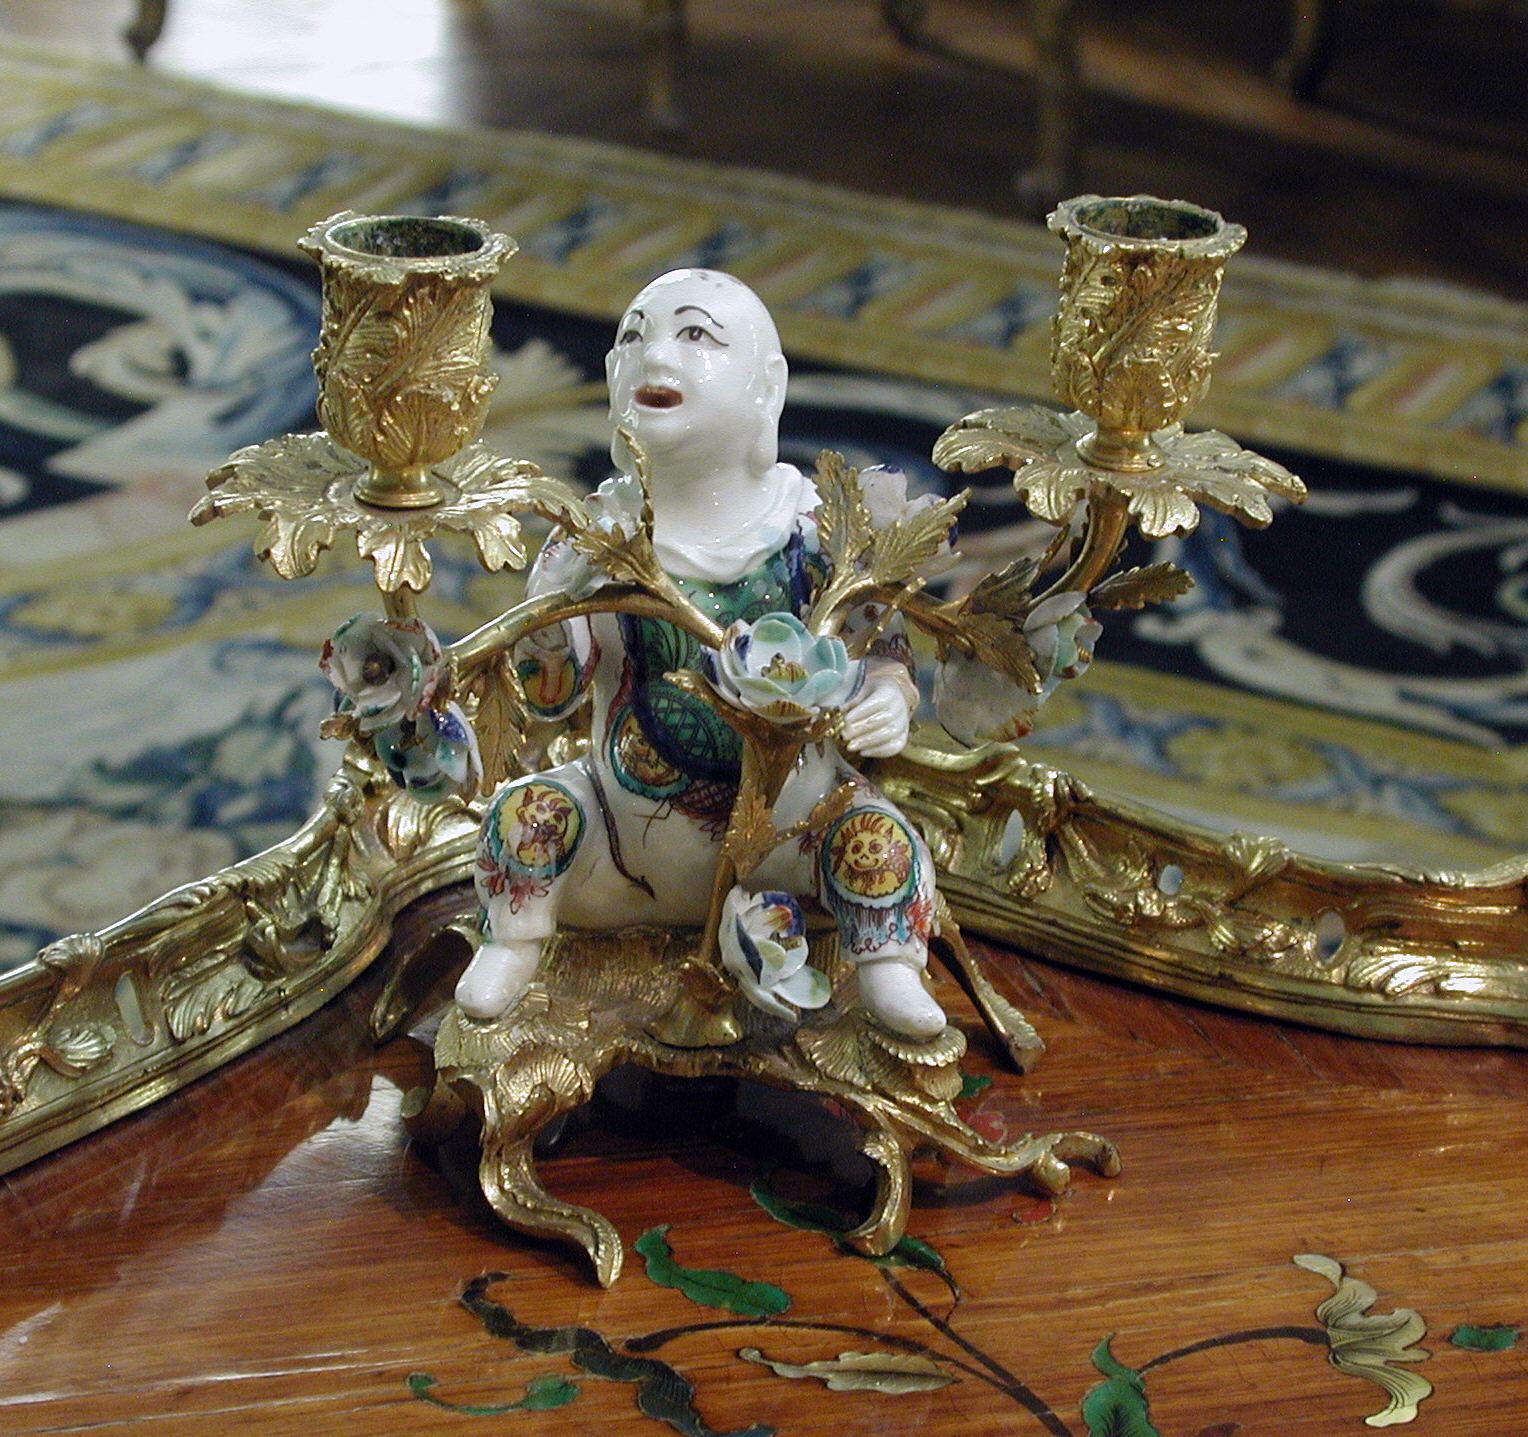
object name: candelabrum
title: Candelabrum (one of a pair)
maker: villeroy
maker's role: factory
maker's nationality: french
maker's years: 1734-1748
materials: gilt bronze, soft paste porcelain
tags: chinoiserie,men